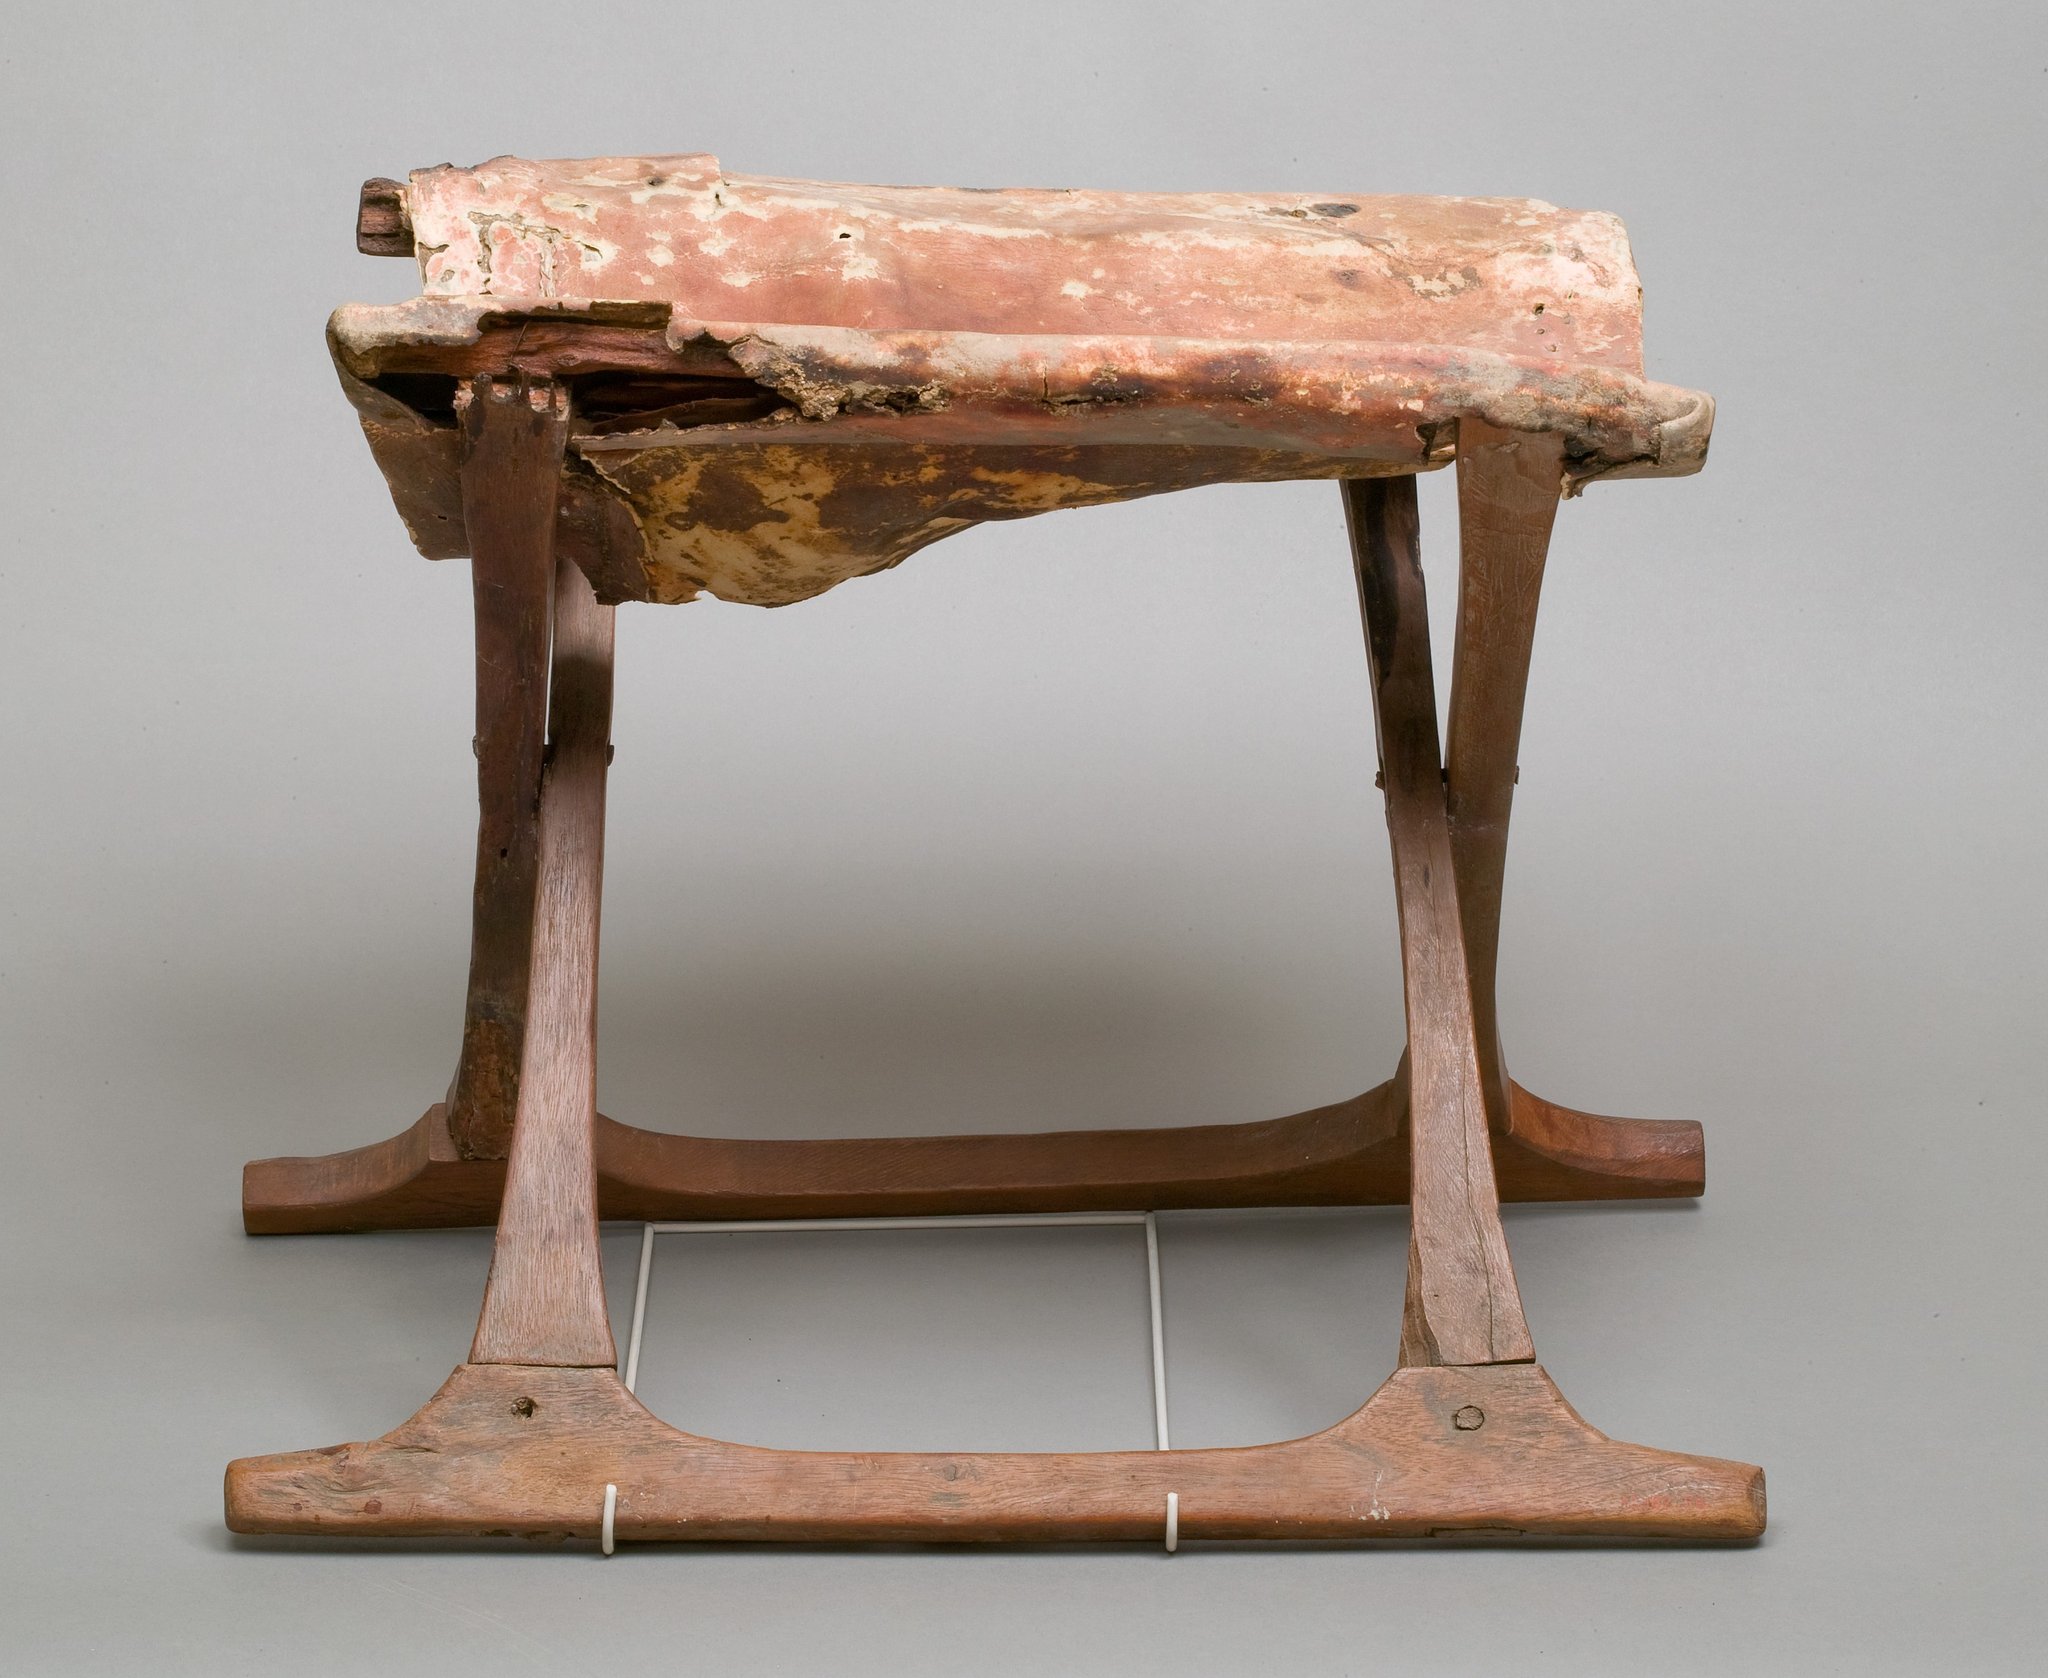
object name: folding stool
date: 2030-1640 BCE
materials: bronze, copper alloy, leather, wood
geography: egypt